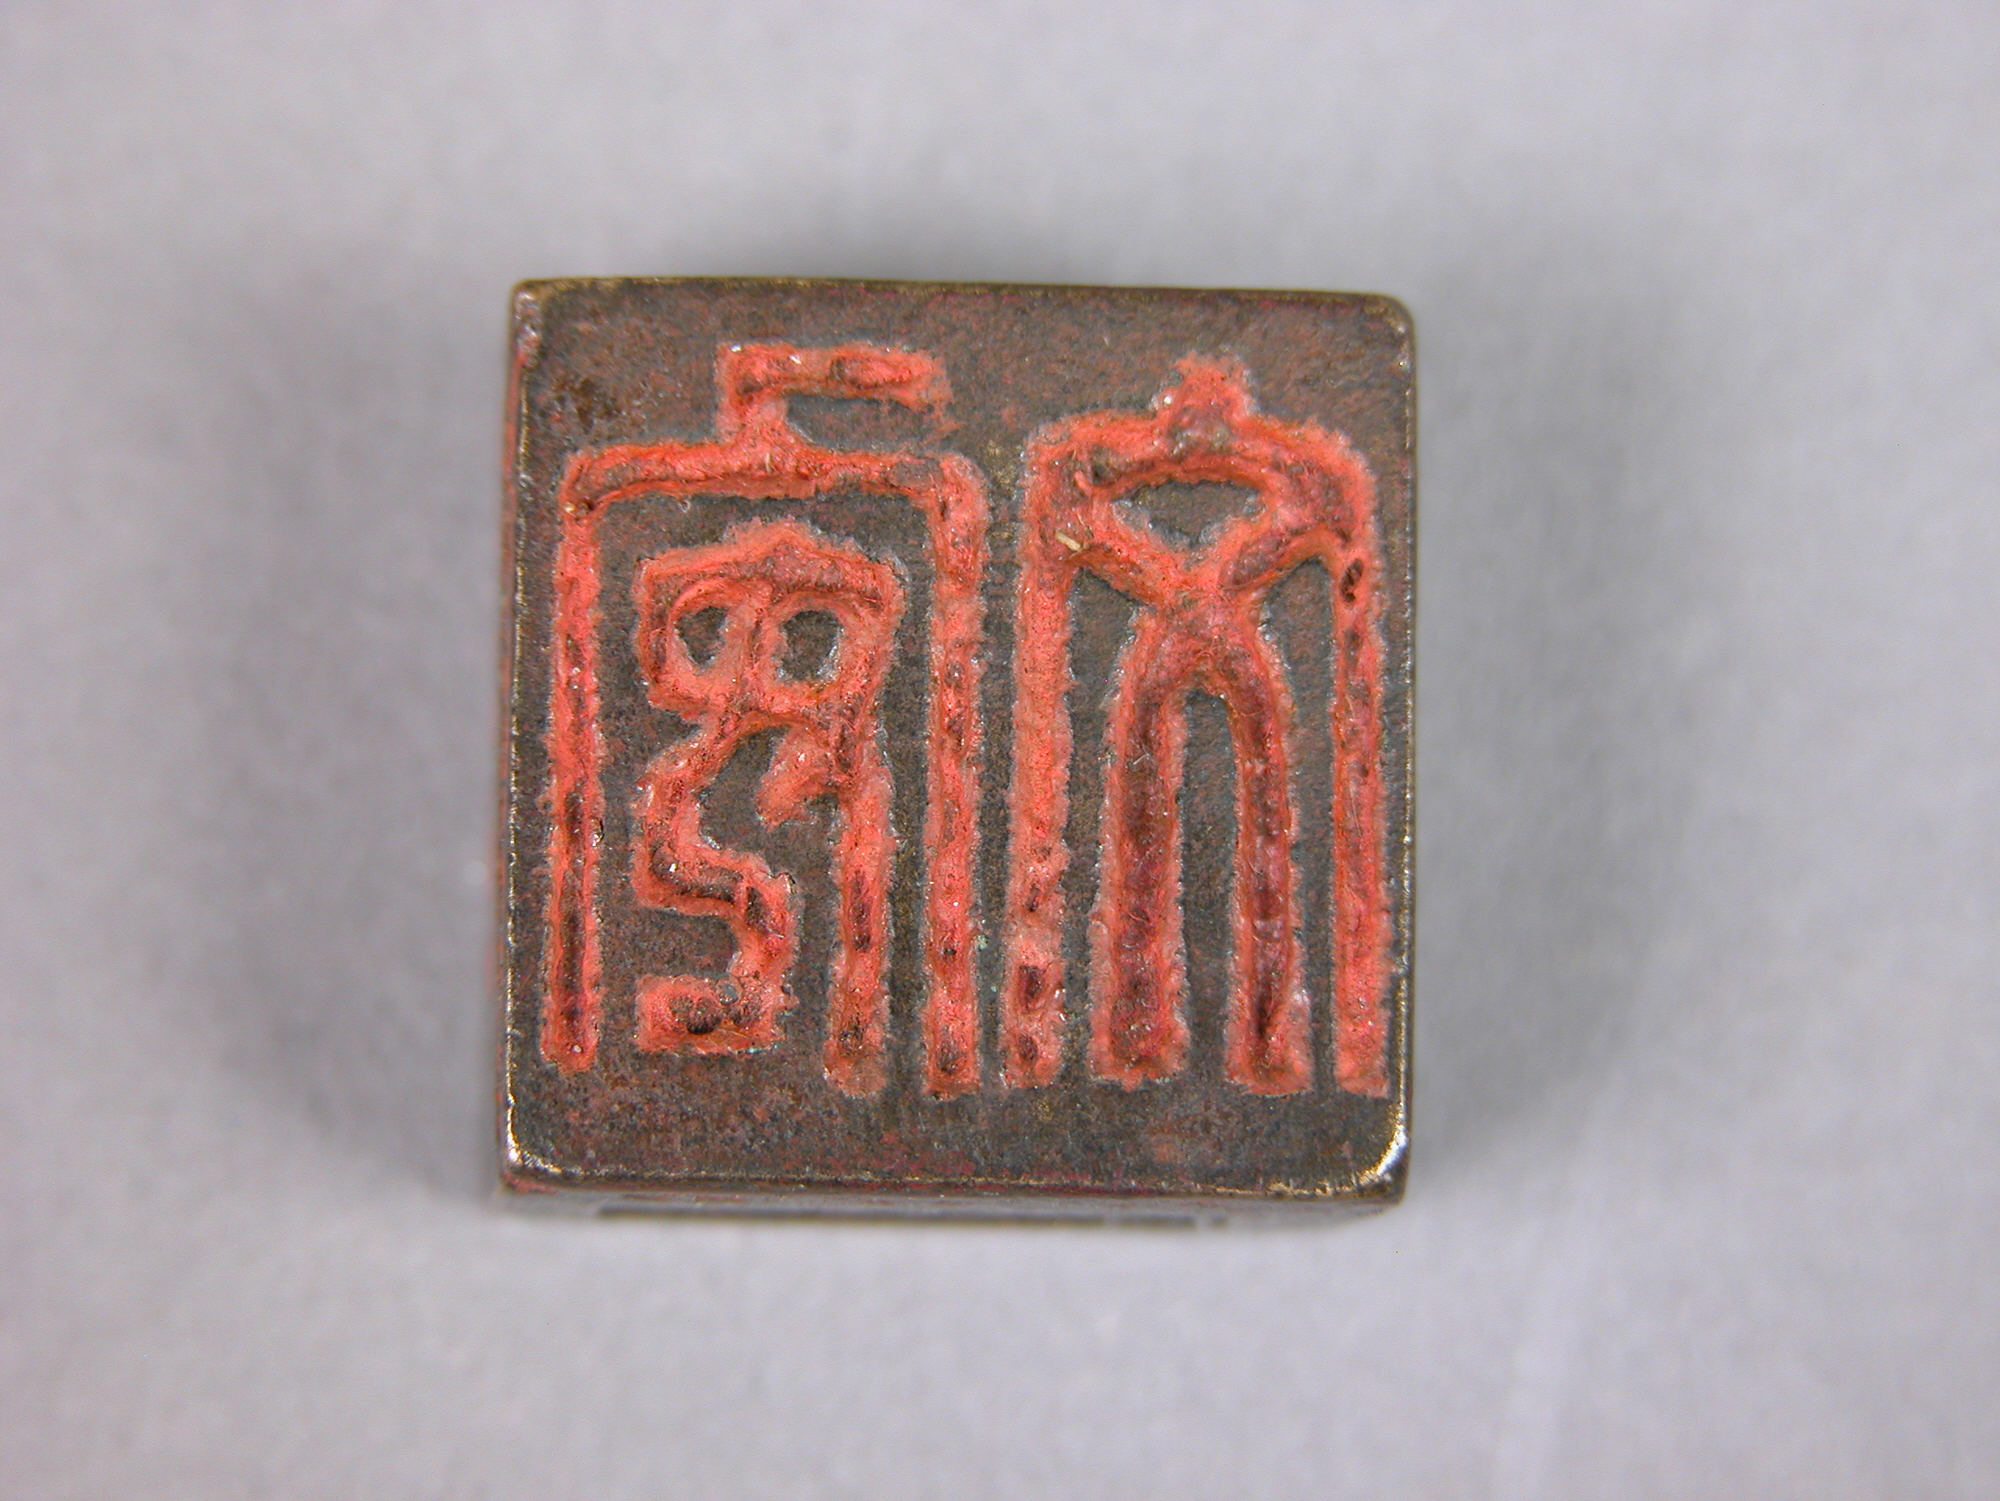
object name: seal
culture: chinese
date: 1300-1644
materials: bronze